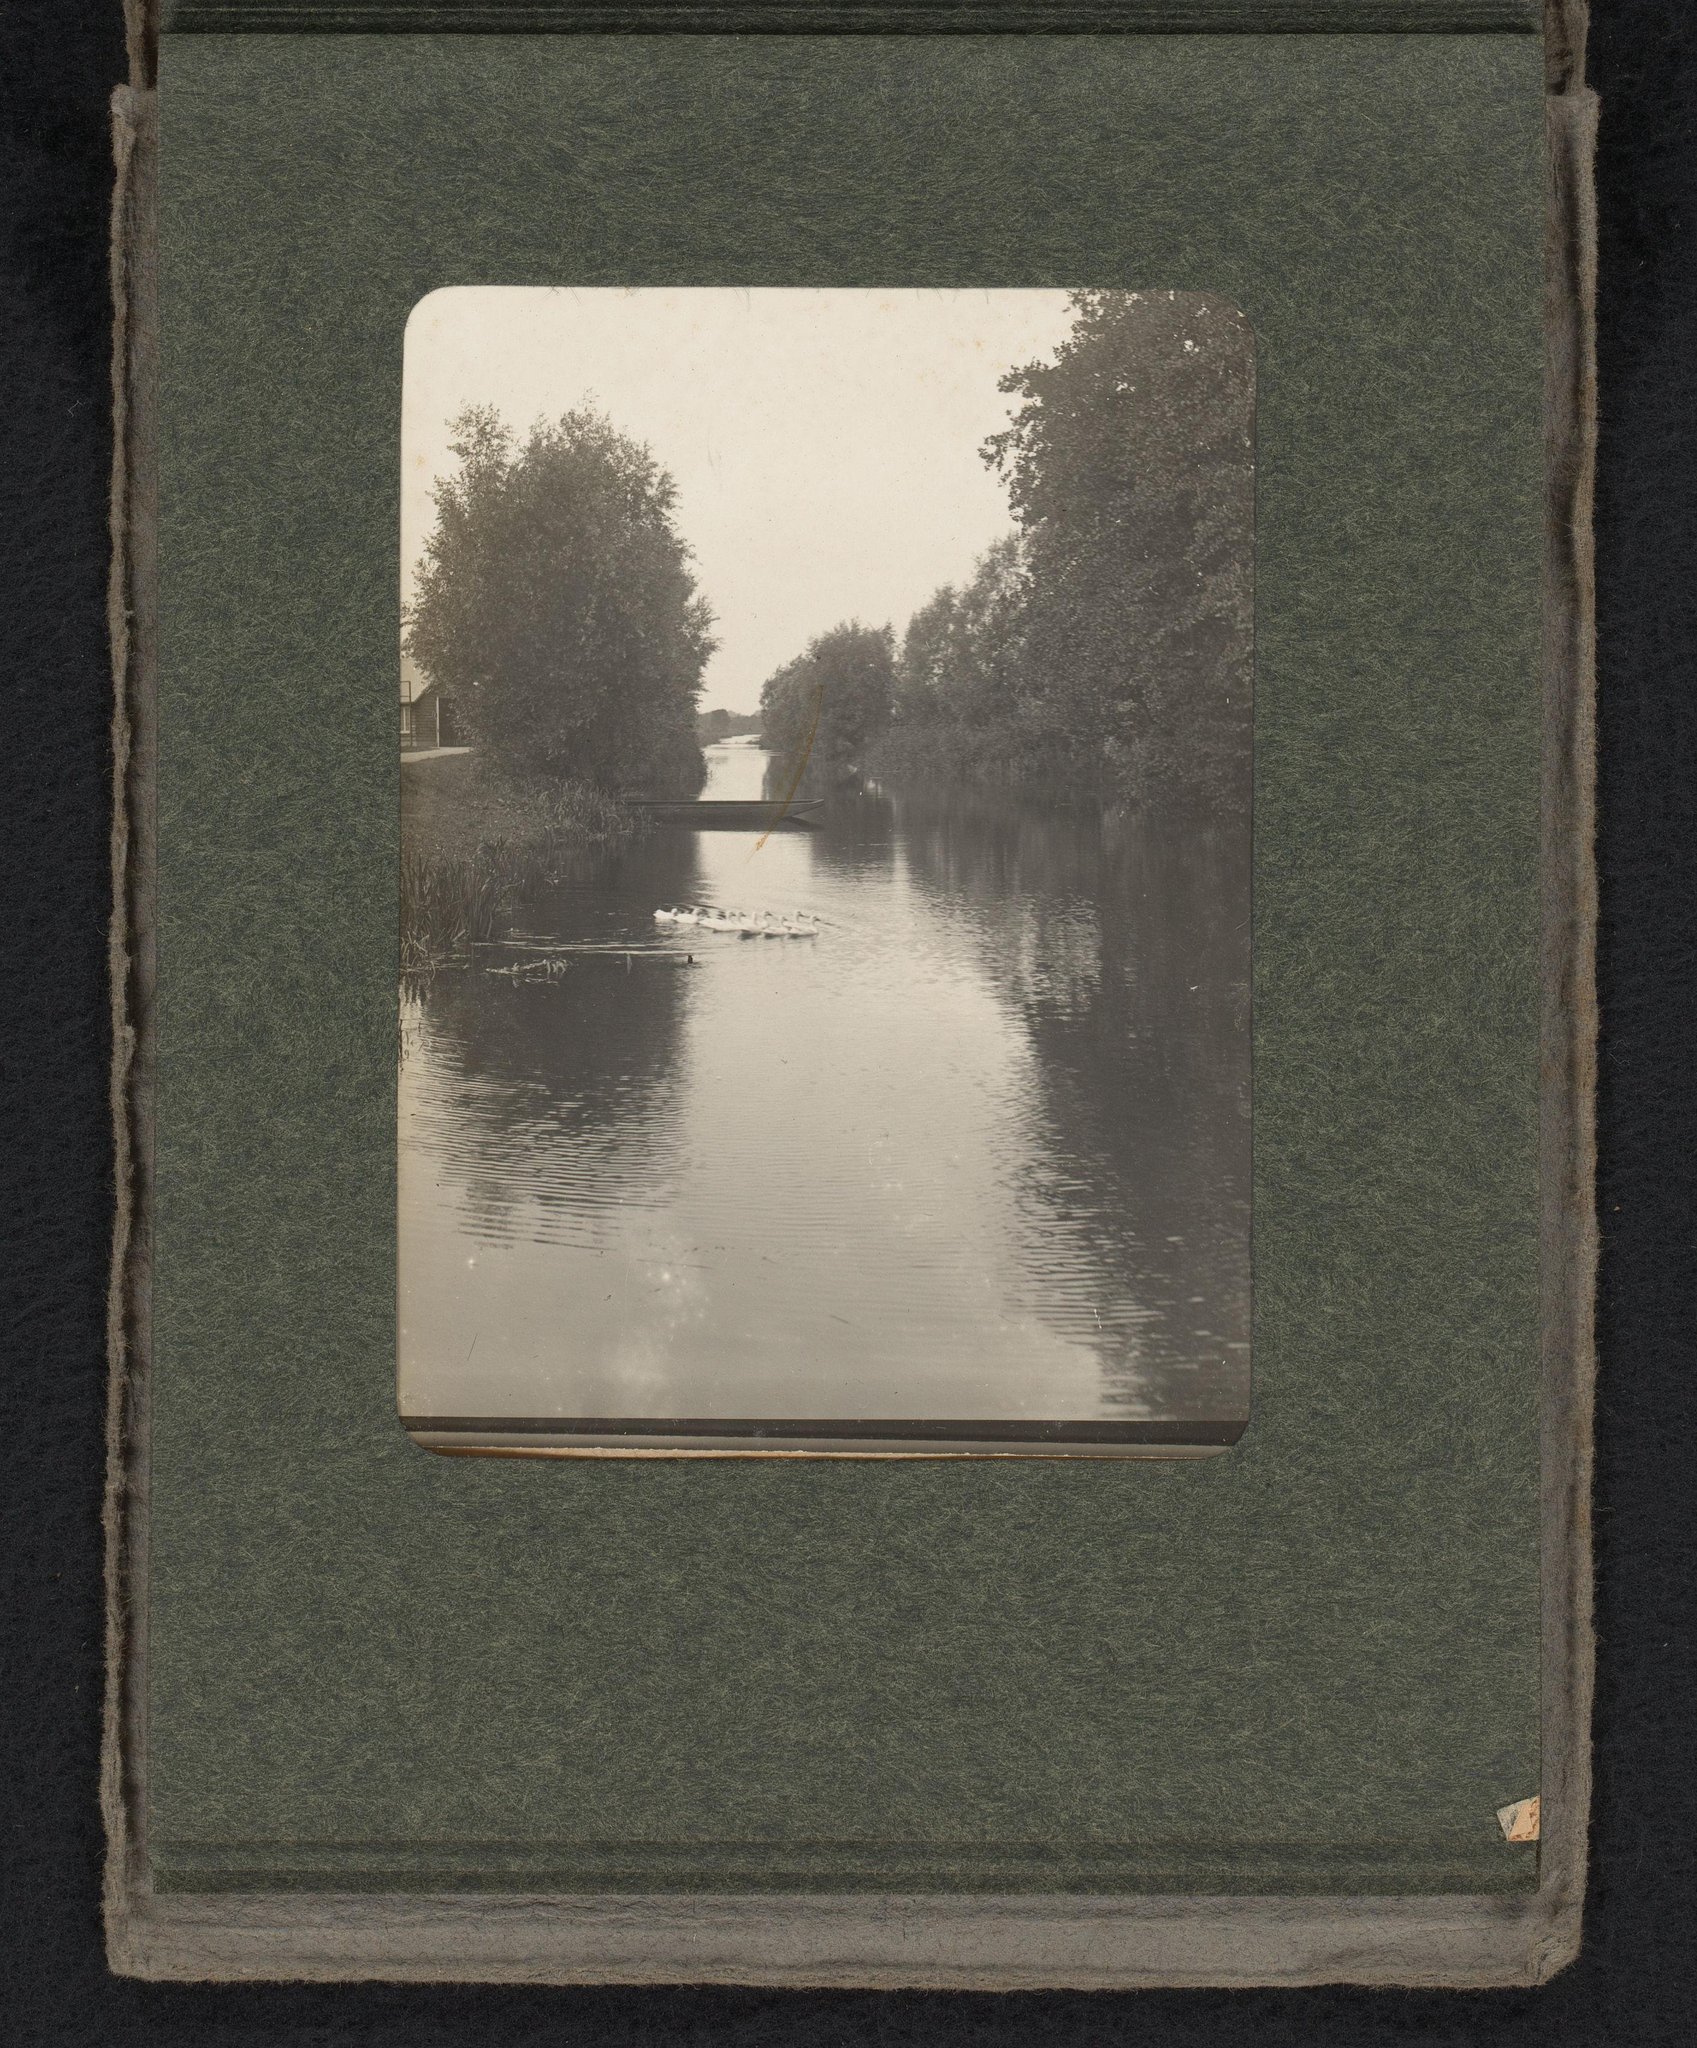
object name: album leaf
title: Eenden in een beek te Laren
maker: hendrik herman van den berg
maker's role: amateurfotograaf, jurist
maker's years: 1875-1944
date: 1912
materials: paper, cardboard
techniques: gelatin silver print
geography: laren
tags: brook, water-birds: duck